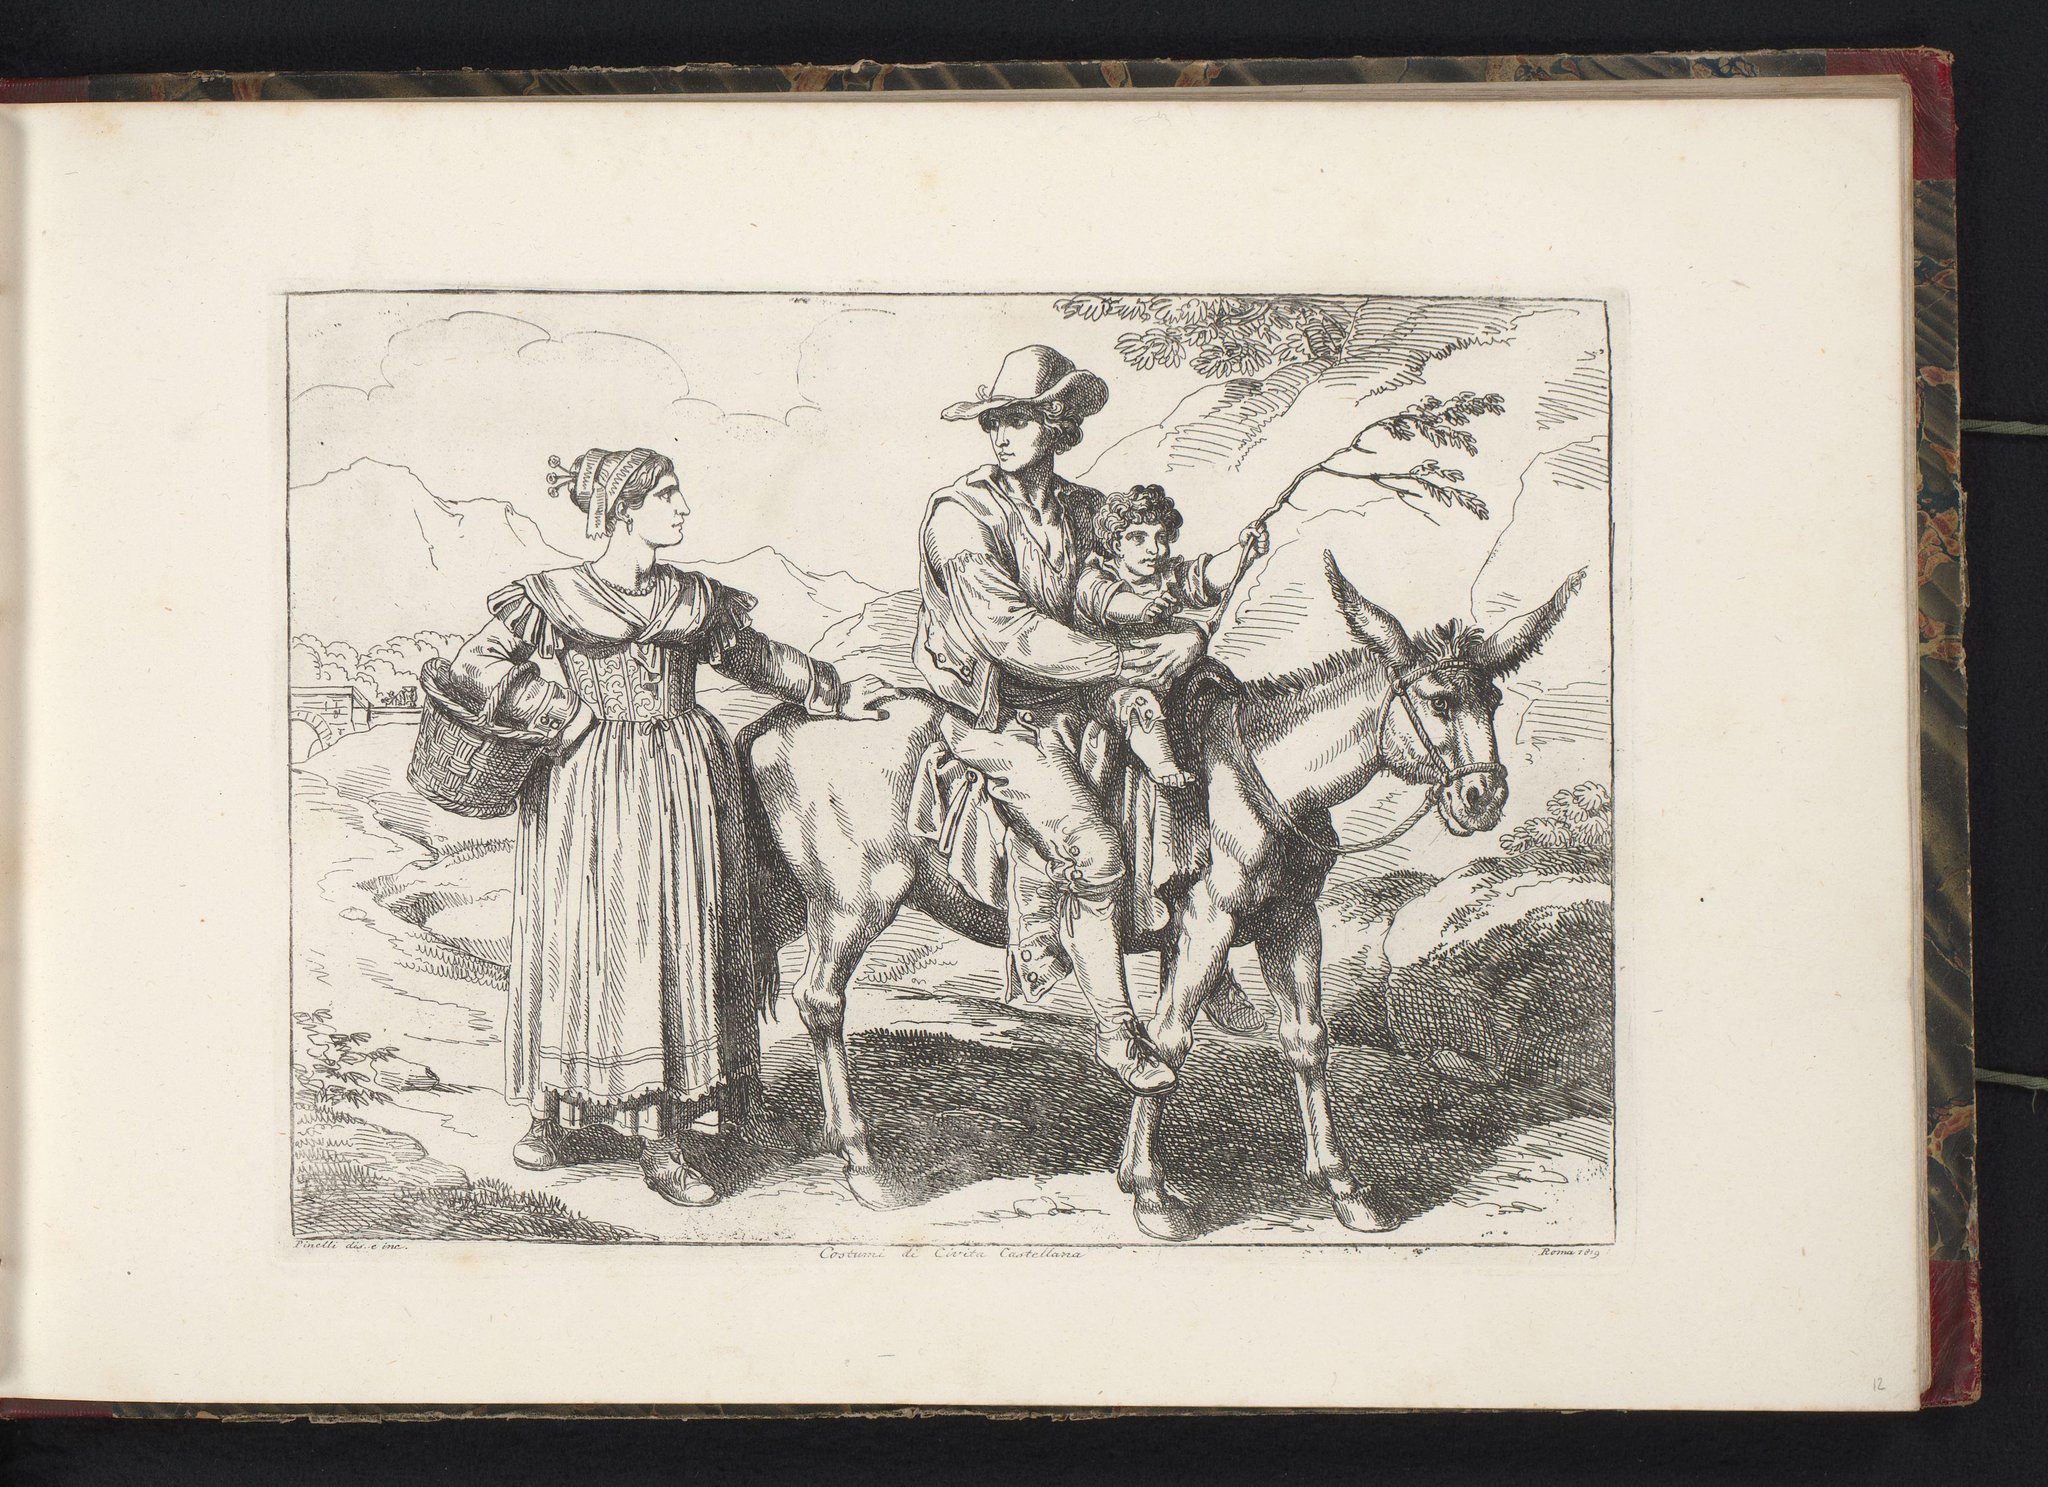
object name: album leaf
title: Gezin uit Civita Castellana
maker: bartolomeo pinelli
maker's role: draughtsman, print maker, sculptor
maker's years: 1781-1835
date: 1819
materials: paper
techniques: etching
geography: rome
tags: riding a horse, ass, or mule; rider, horseman, city-view, and landscape with man-made constructions, ass, donkey, container made of plant material other than wood: basket, folk costume, regional costume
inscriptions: date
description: Landschap met een jongeman en kind zittend op een ezel. Naast de ezel staat een jonge vrouw die een mand draagt. De prent maakt deel uit van een album.